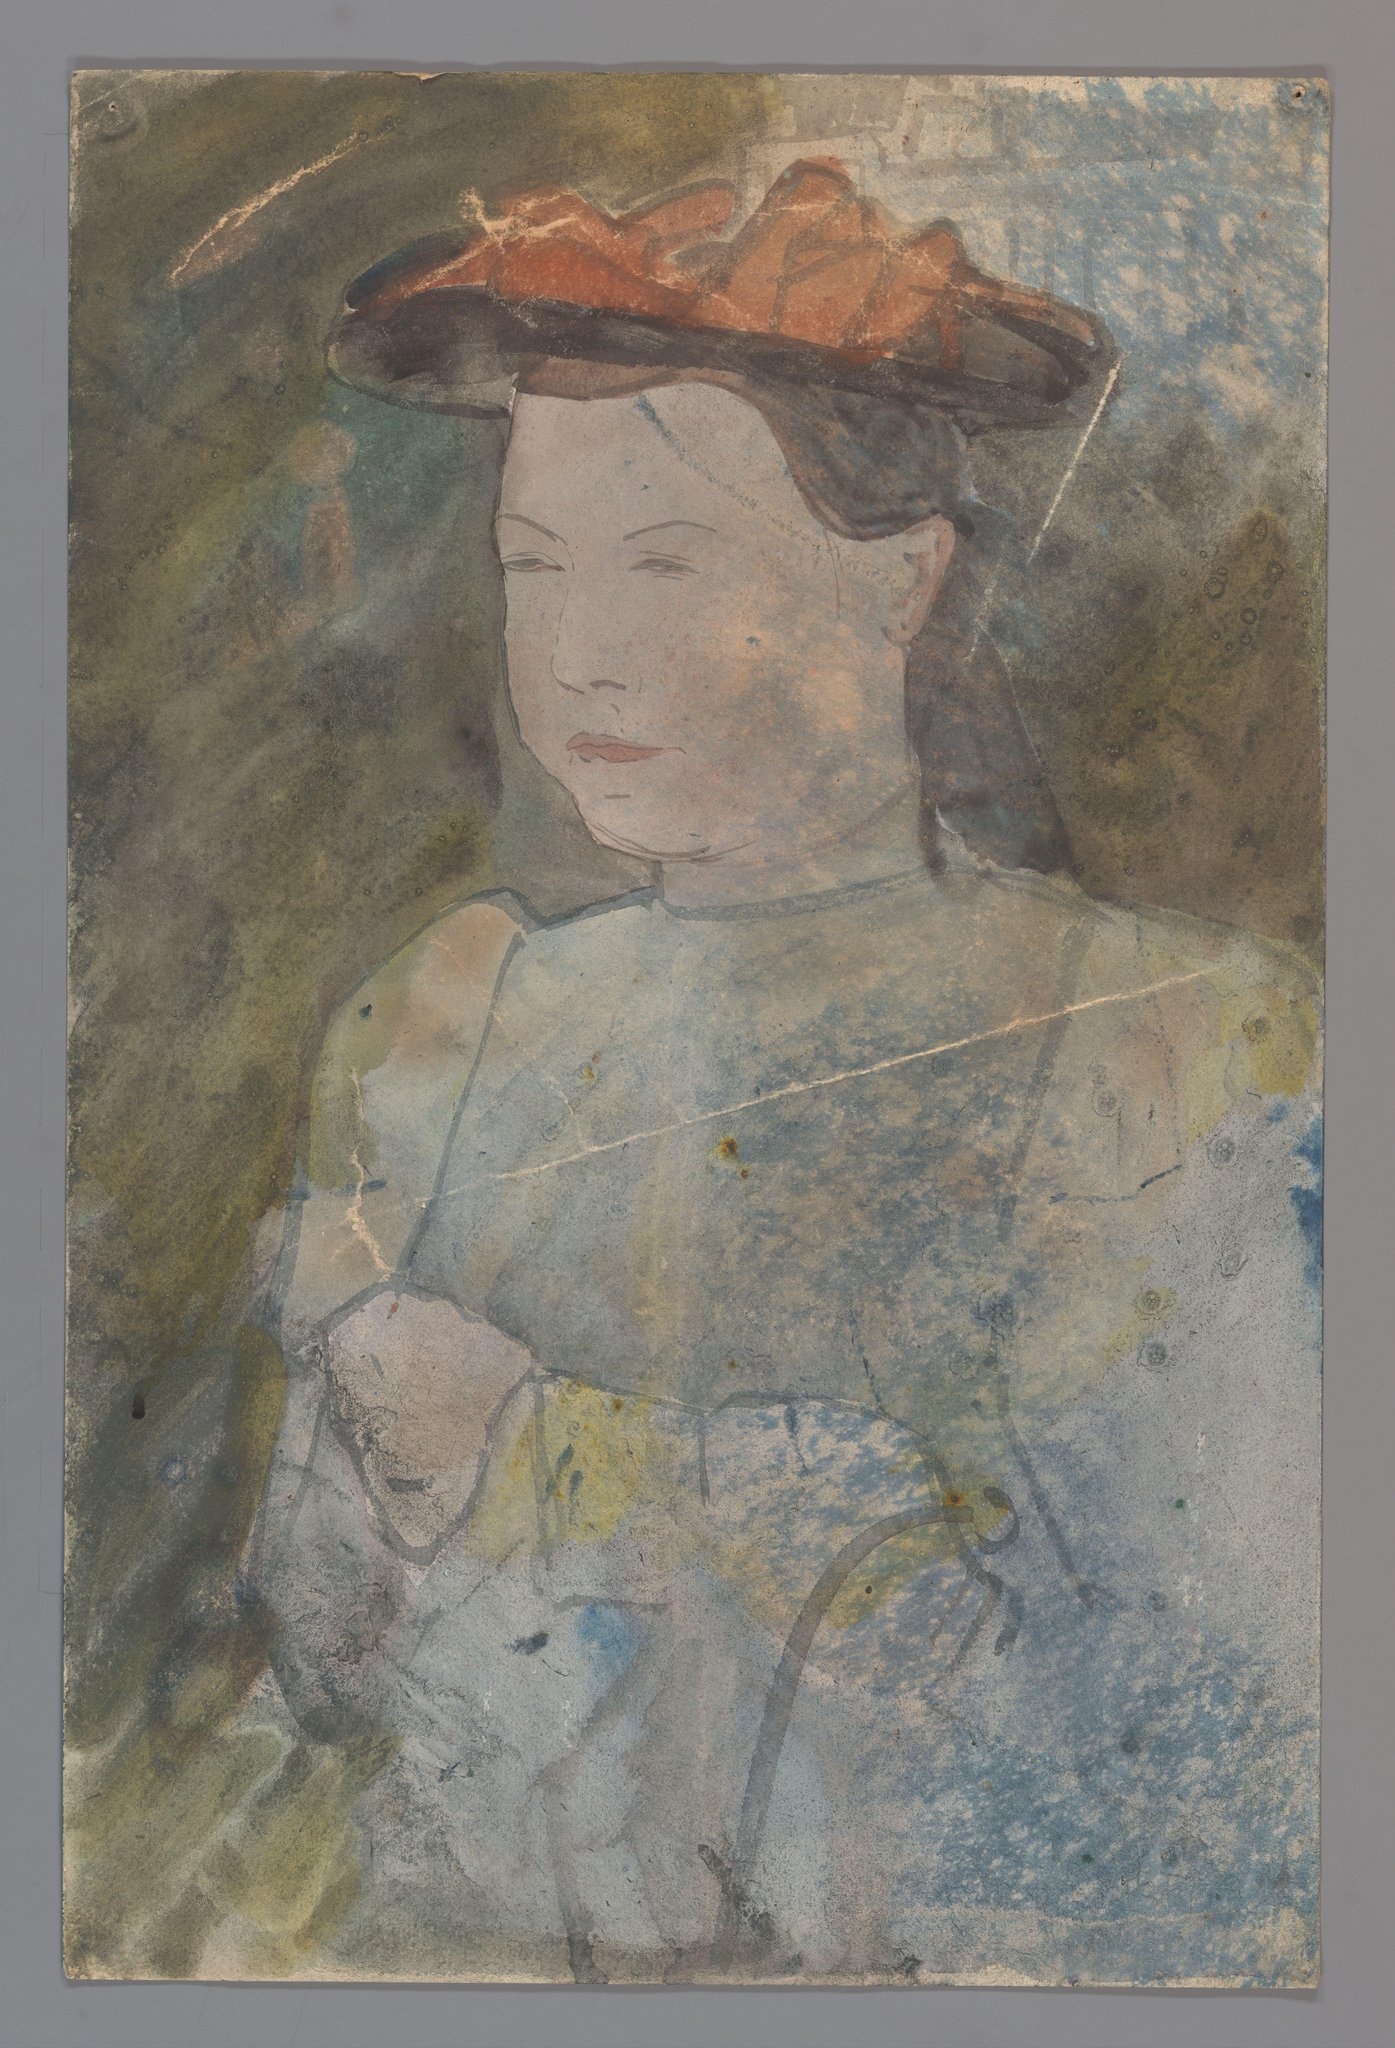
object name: drawing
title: Vrouw met een platte hoed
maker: carel adolph lion cachet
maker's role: draughtsman, print maker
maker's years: 1864-1945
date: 1874-1945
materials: paper, watercolor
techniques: brush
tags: anonymous historical person portrayed alone